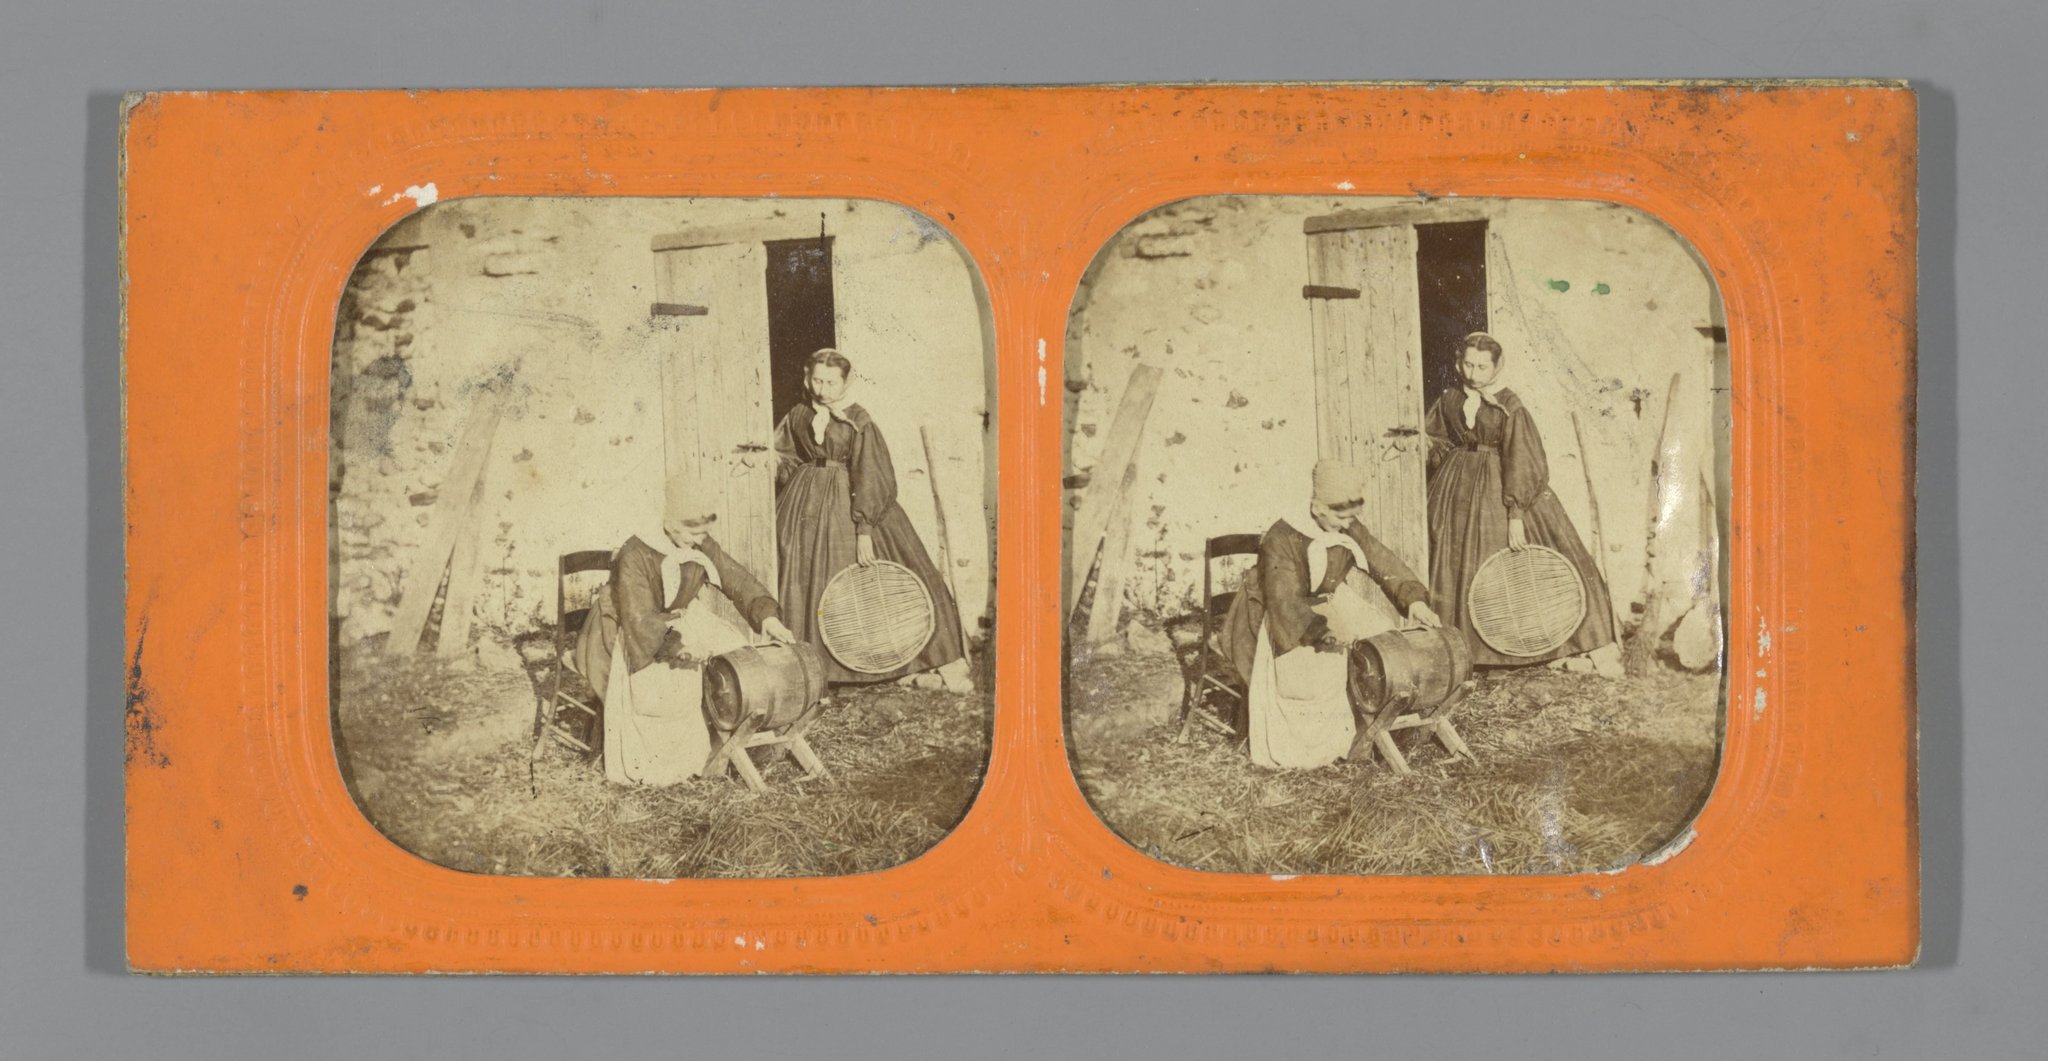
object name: tissue stereograph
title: Twee vrouwen met ton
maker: Anonymous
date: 1855-1875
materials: cardboard, paper, photographic support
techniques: albumen print, hand coloring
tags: wooden container: barrel, cask, bucket